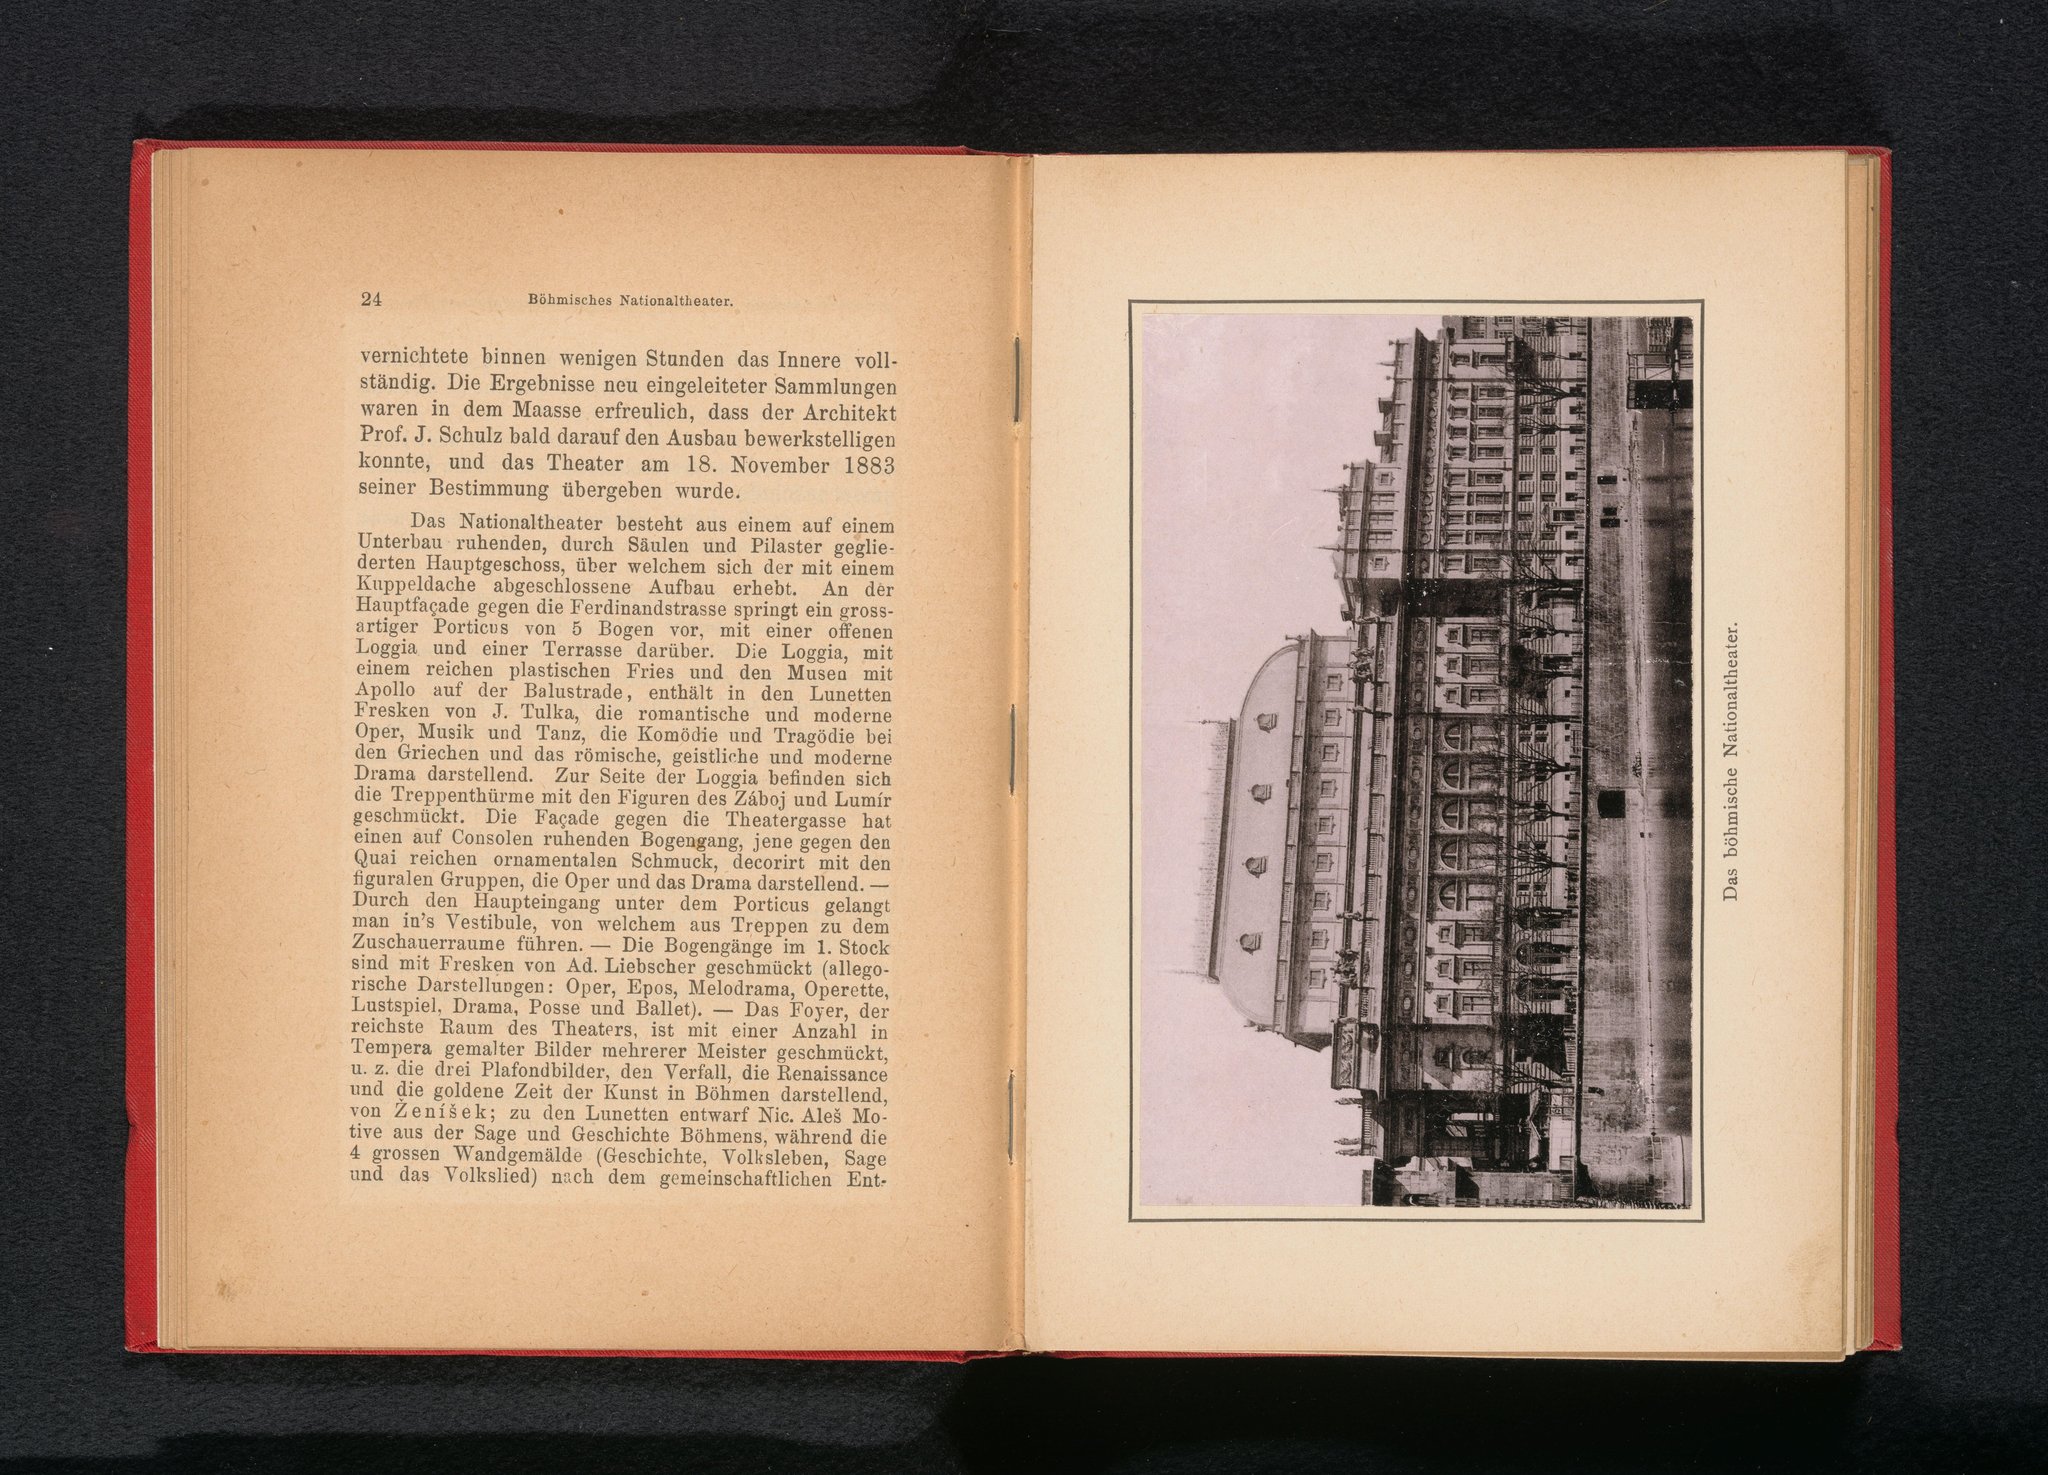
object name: photomechanical print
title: Das böhmische Nationaltheater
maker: Anonymous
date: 1885-1890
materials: paper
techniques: photograph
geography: prague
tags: theatre (building), façade (of house or building)